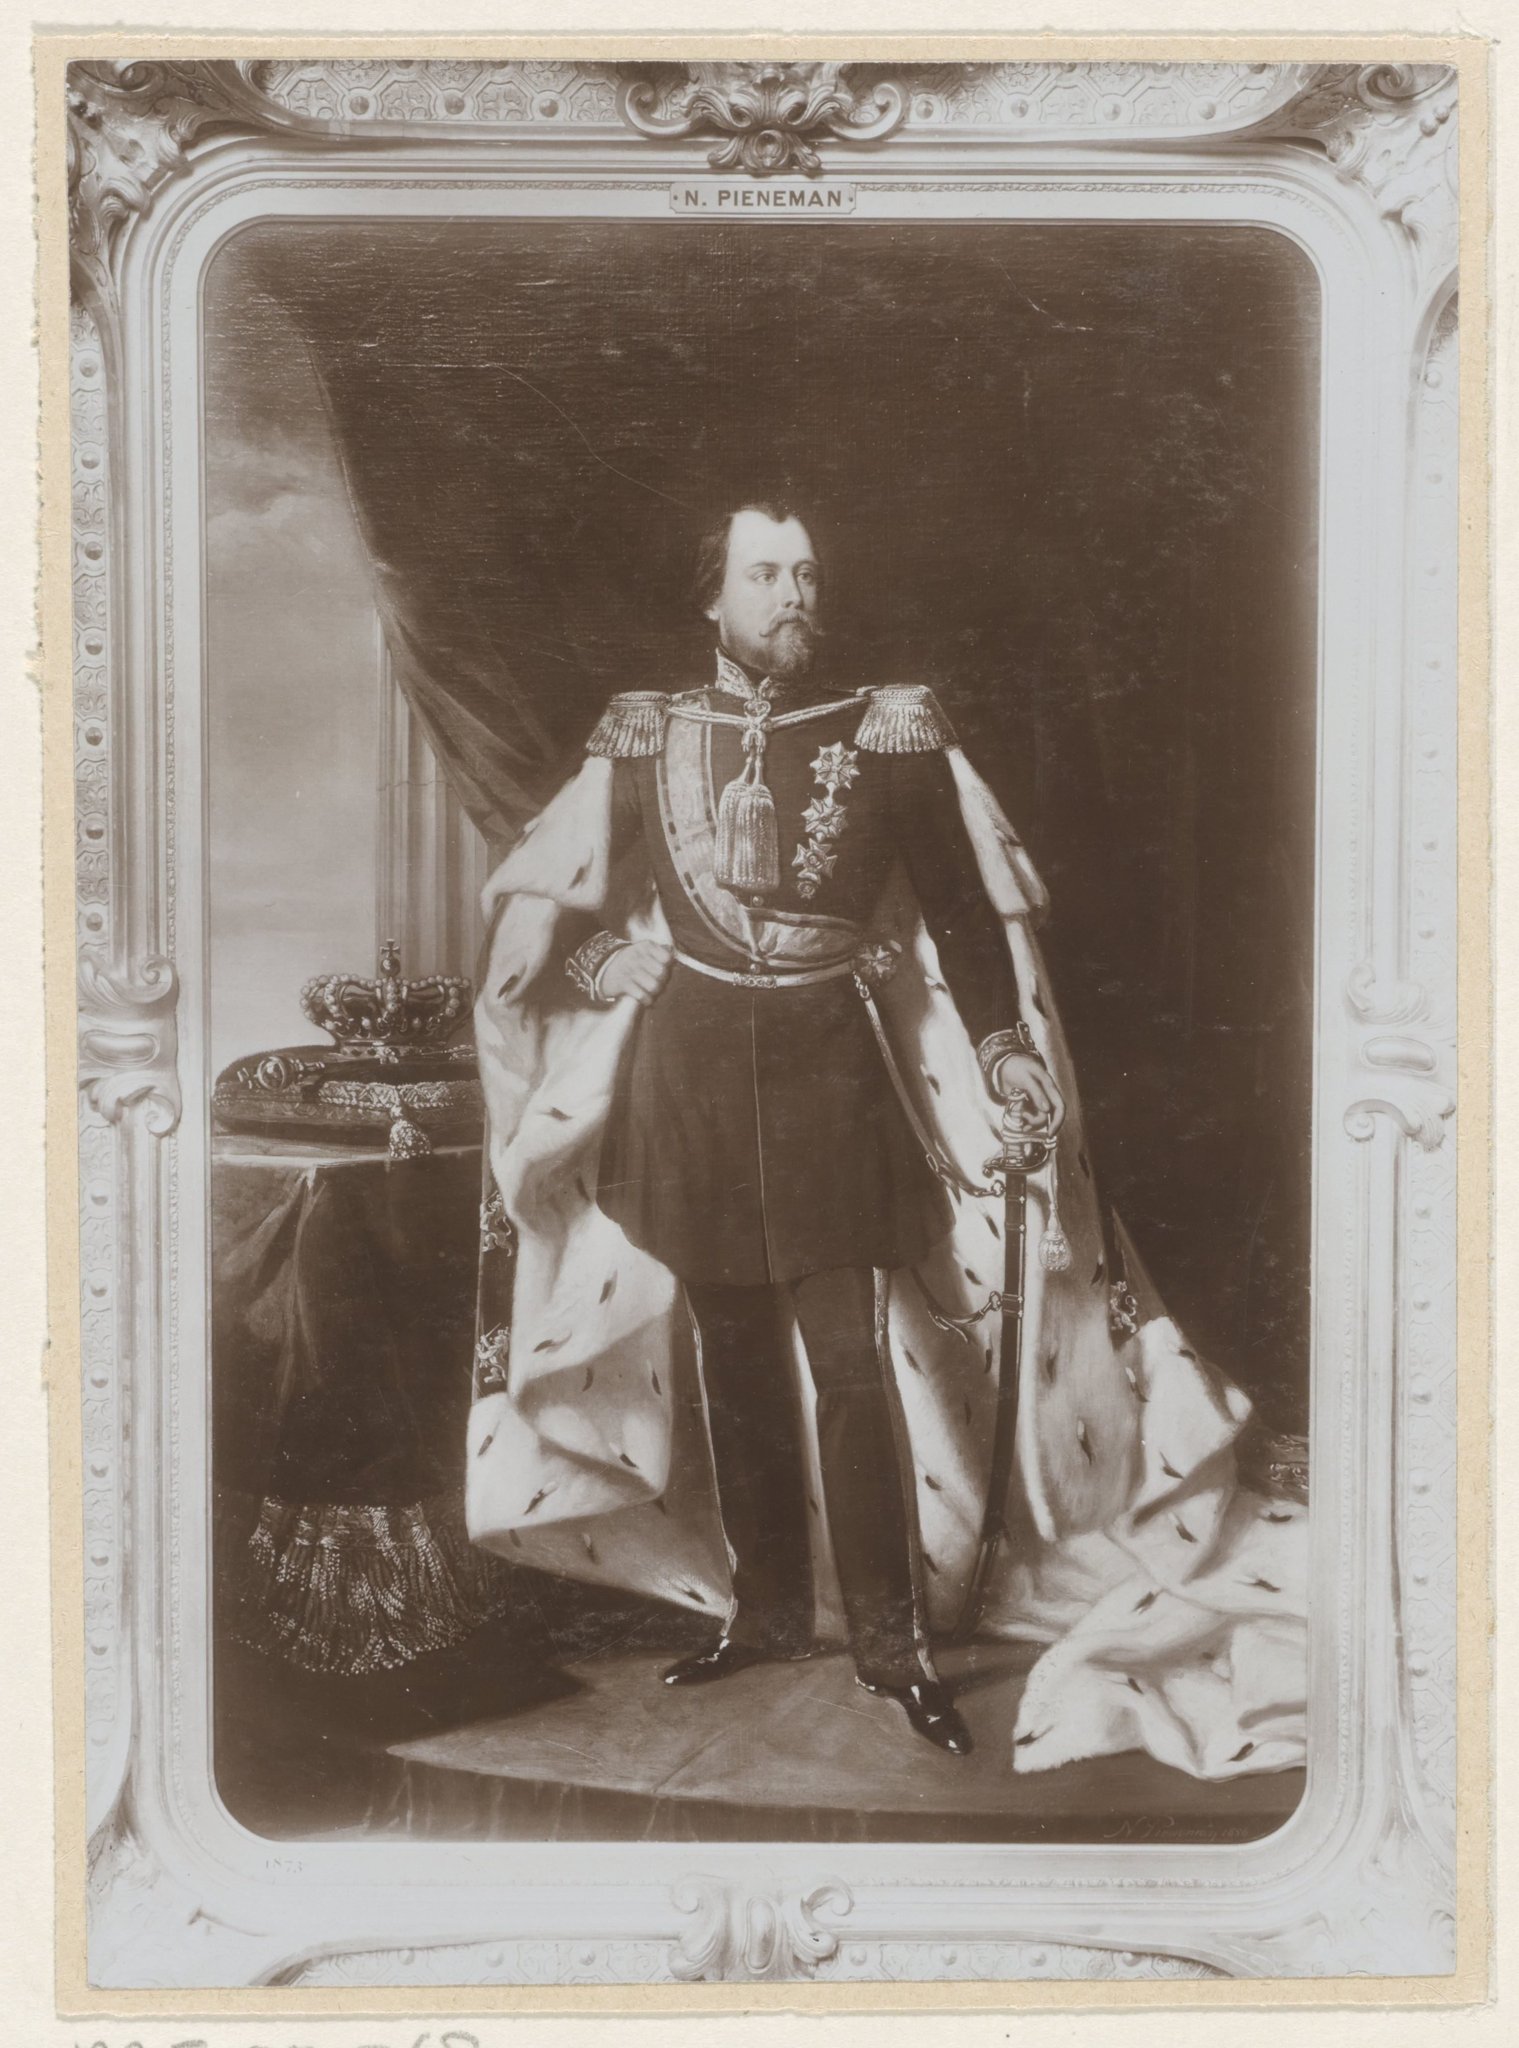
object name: photograph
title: Portret van Willem III, koning der Nederlanden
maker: Anonymous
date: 1850-1912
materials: photographic support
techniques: collodion silver print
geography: netherlands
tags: brussels, willem iii (koning der nederlanden)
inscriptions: collector's mark: Lugt 2228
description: De hier vermelde titel verwijst naar de hoogst verkregen titel van de geportretteerde, niet per se naar de titel die de geportretteerde op deze voorstelling draagt.